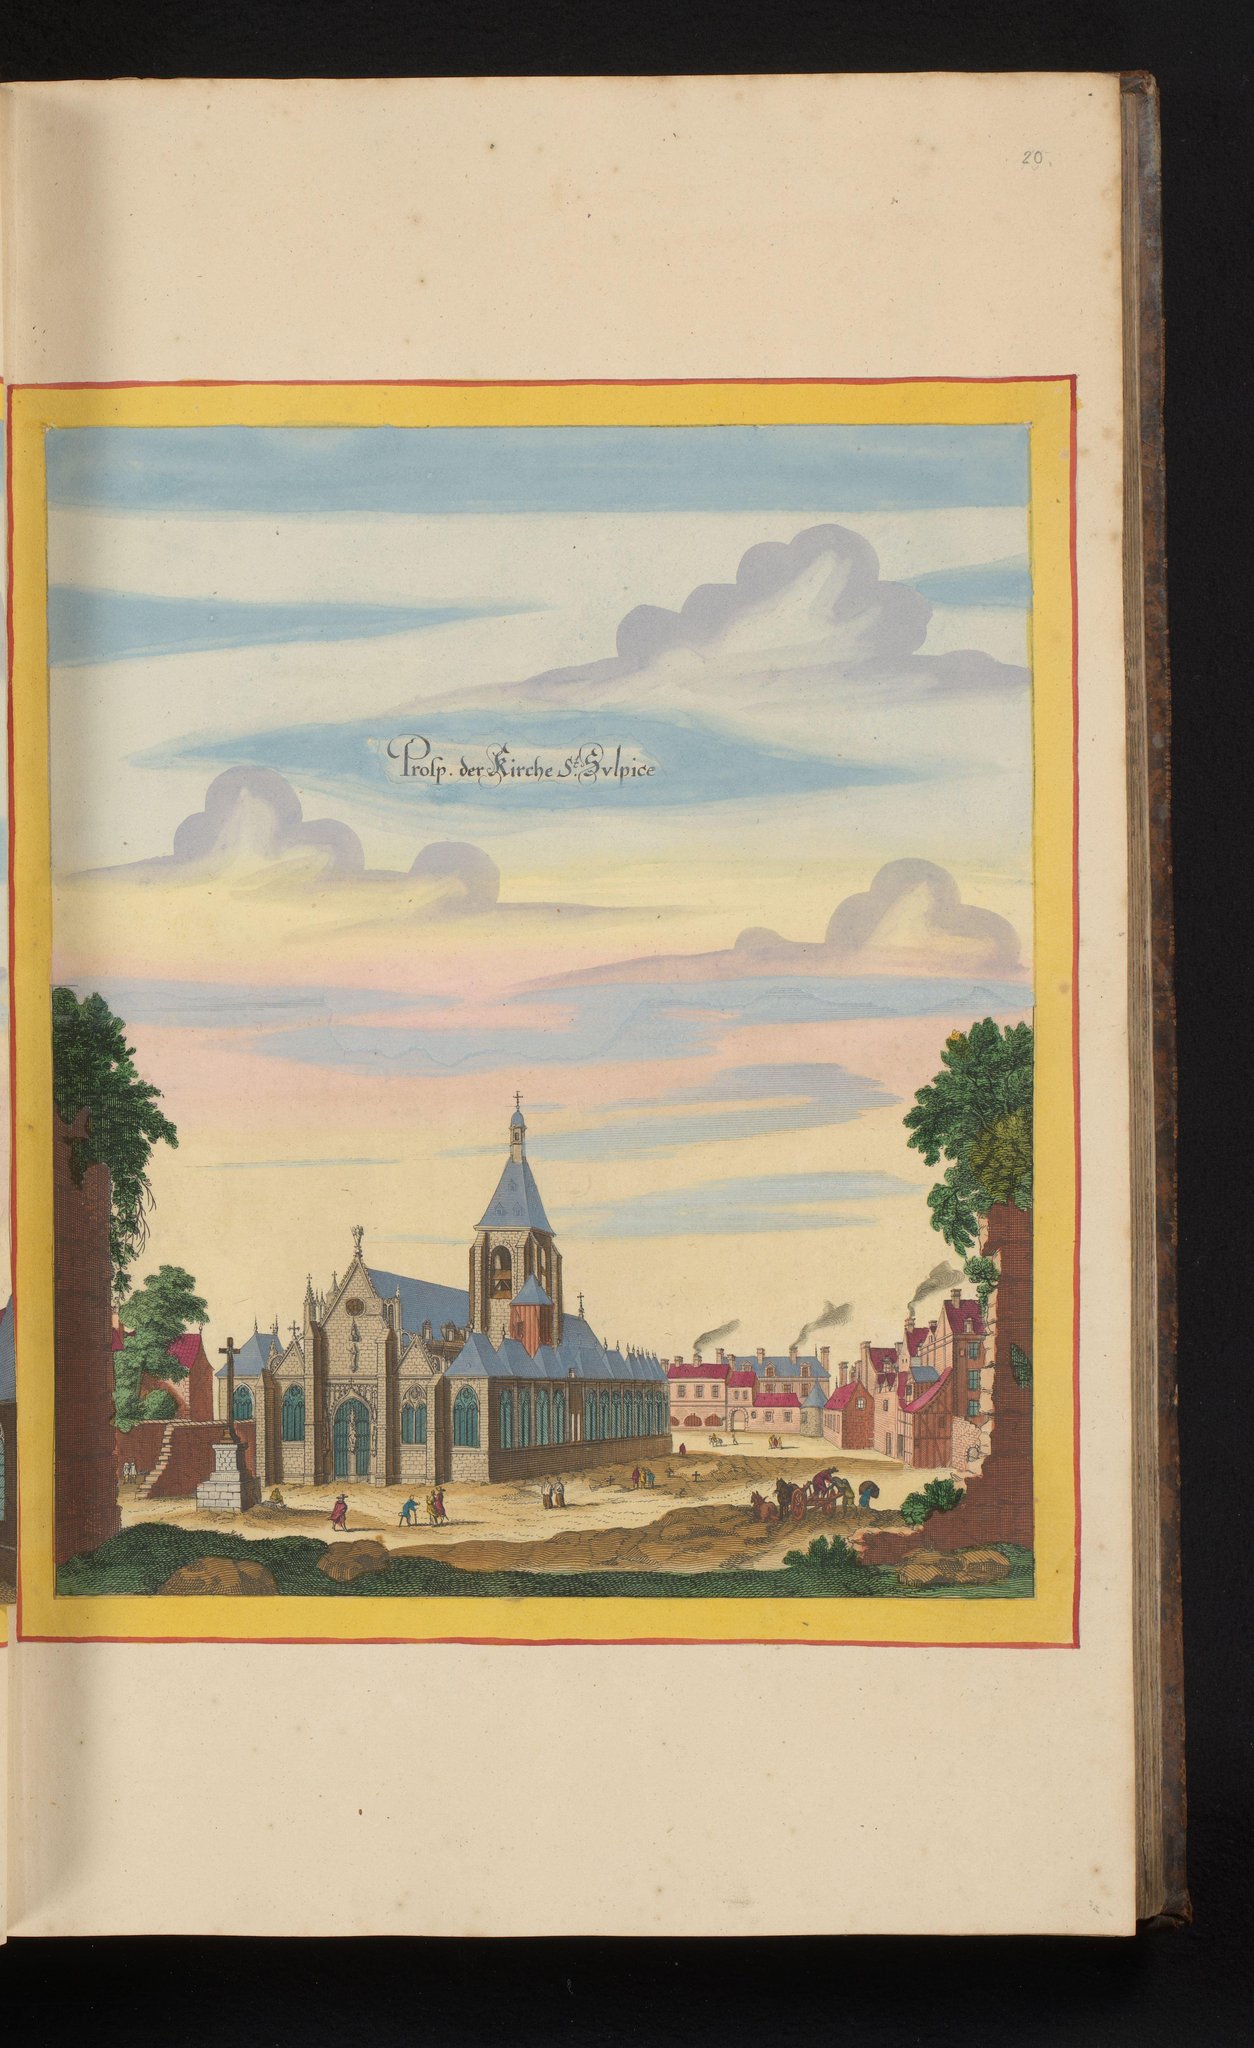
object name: print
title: Gezicht op de kerk van Saint-Sulpice te Parijs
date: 1655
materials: paper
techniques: engraving, etching, hand coloring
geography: frankfurt am main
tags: church (exterior)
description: Prent origineel vervaardigd als boekillustratie voor: Zeiller, Martin. Topographia Galliae, oder Beschreibung und Contrafaitung der vornehmbsten und bekantisten Oerter in dem mächtigen und grossen Königreich Frankreich, 13 delen. Frankfurt am Main: Caspar Merian, 1655-1661. De prent werd voor het eerst gepubliceerd in deel 1: Topographia Galliae, 1655.